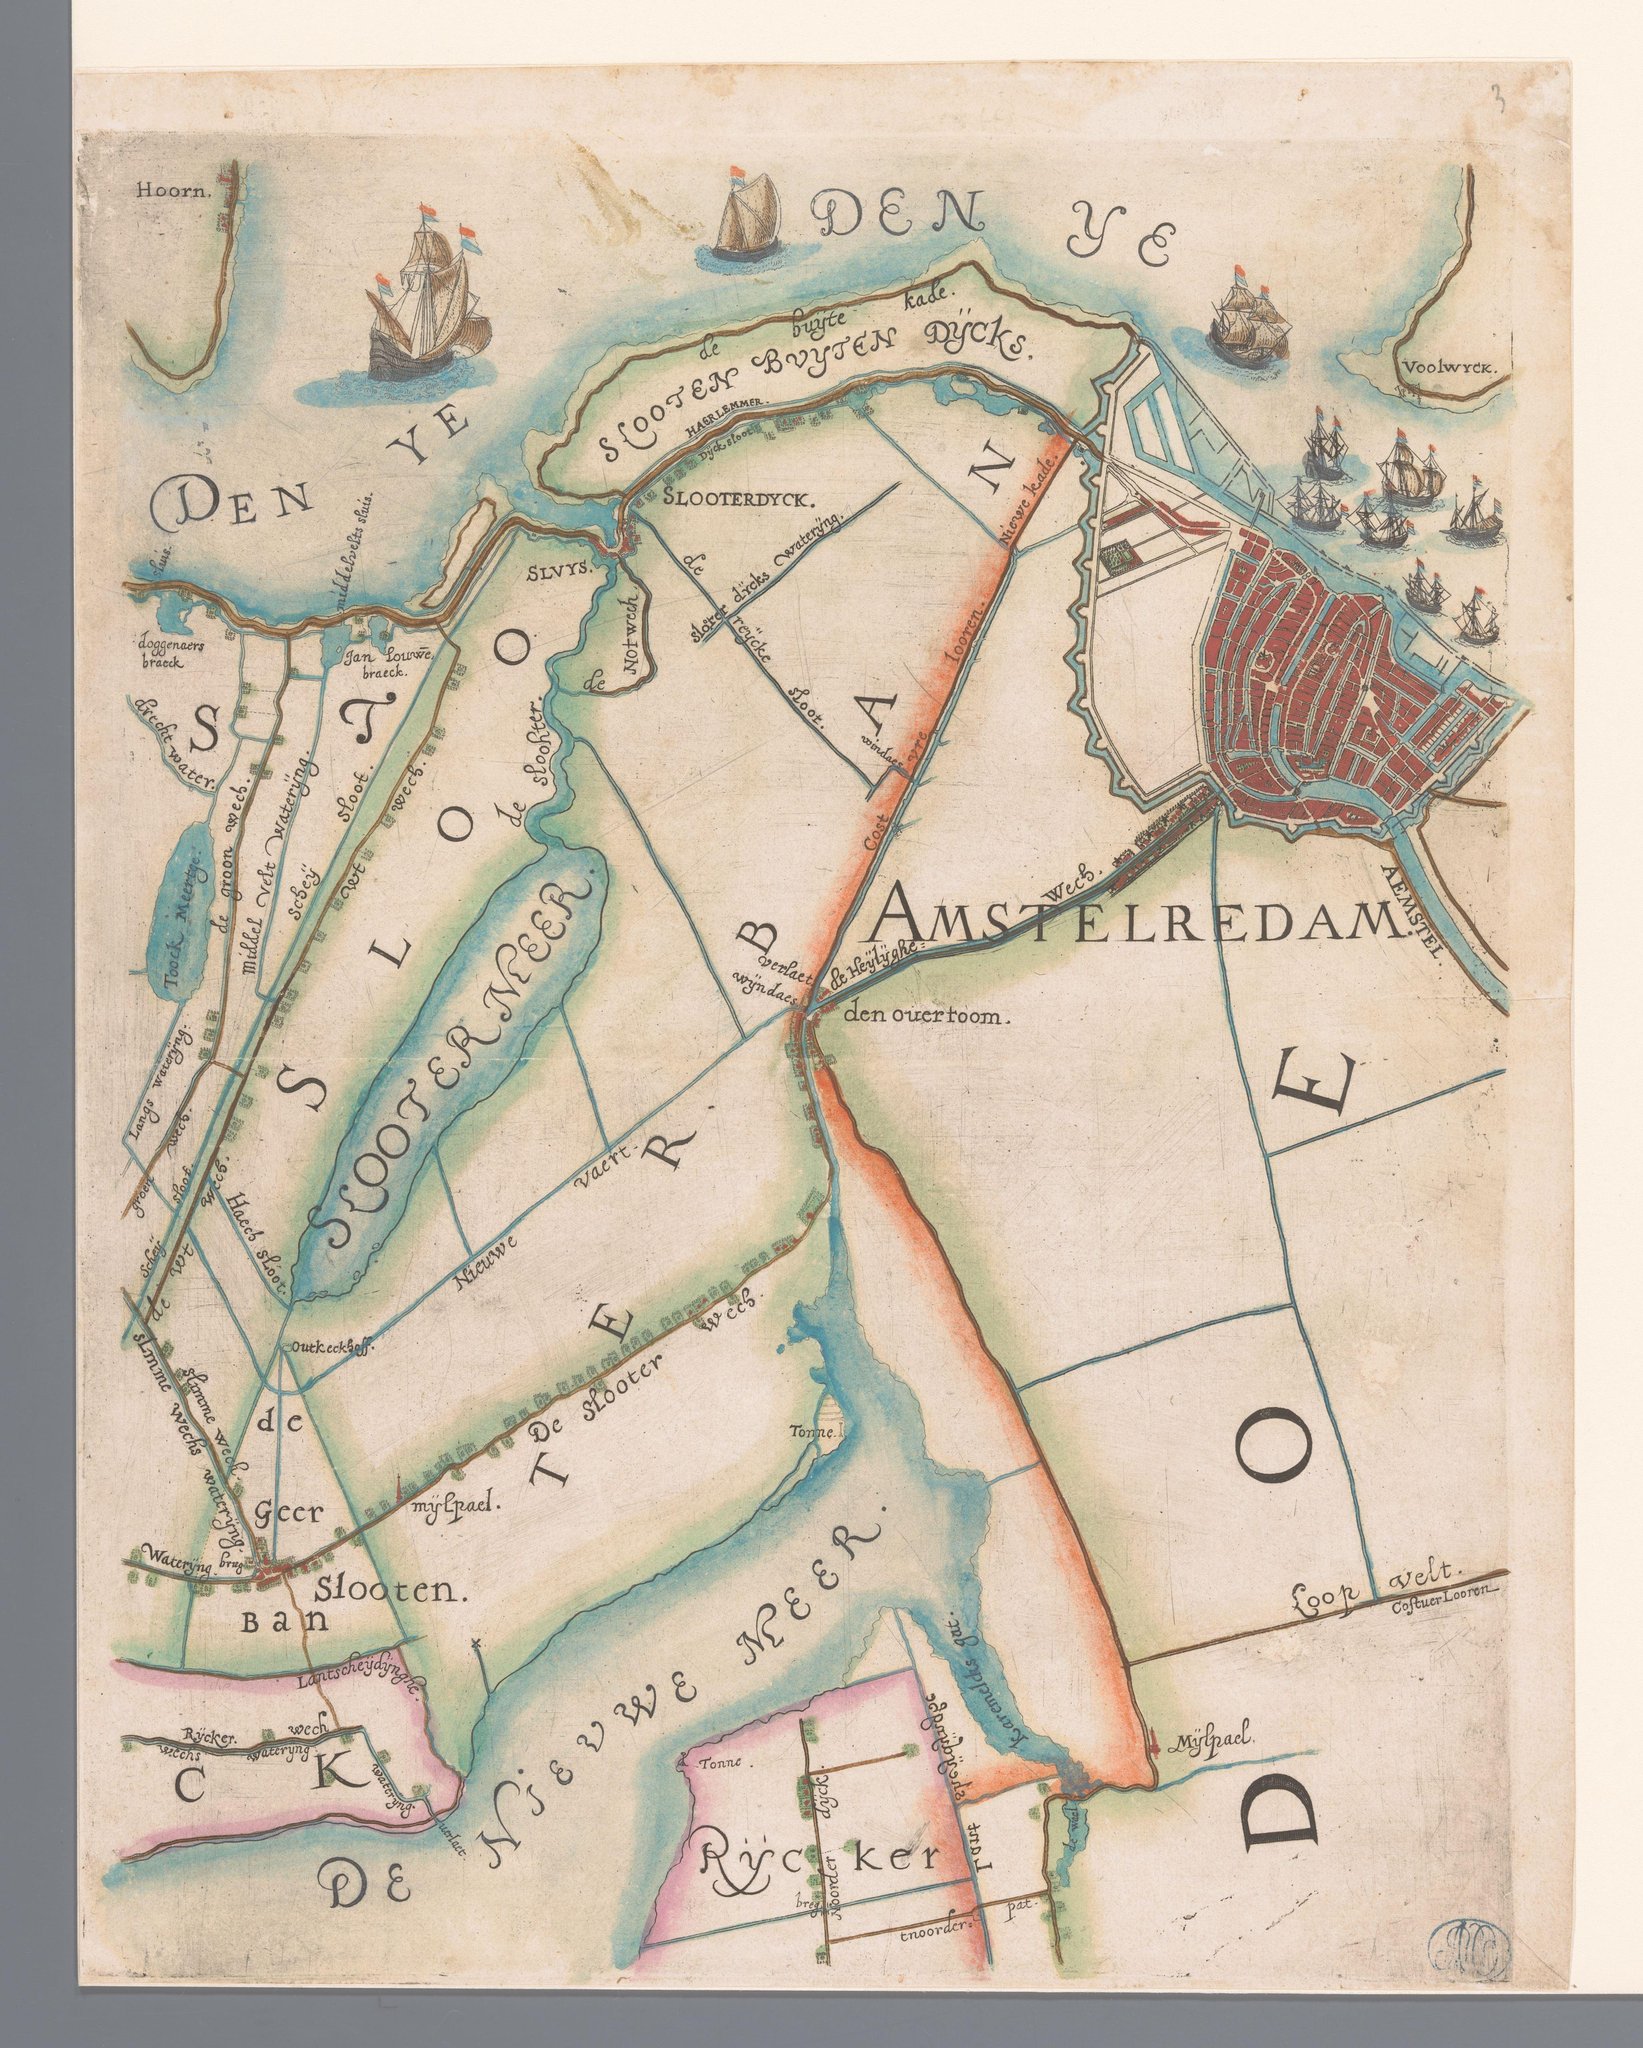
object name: print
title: Deel van een kaart van Rijnland, met Amsterdam en omgeving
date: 1615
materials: paper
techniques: engraving, etching, hand coloring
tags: maps of separate countries or regions, amsterdam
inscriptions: collector's mark: Lugt 195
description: Deel van een kaart van Rijnland, bestaande uit 27 delen.